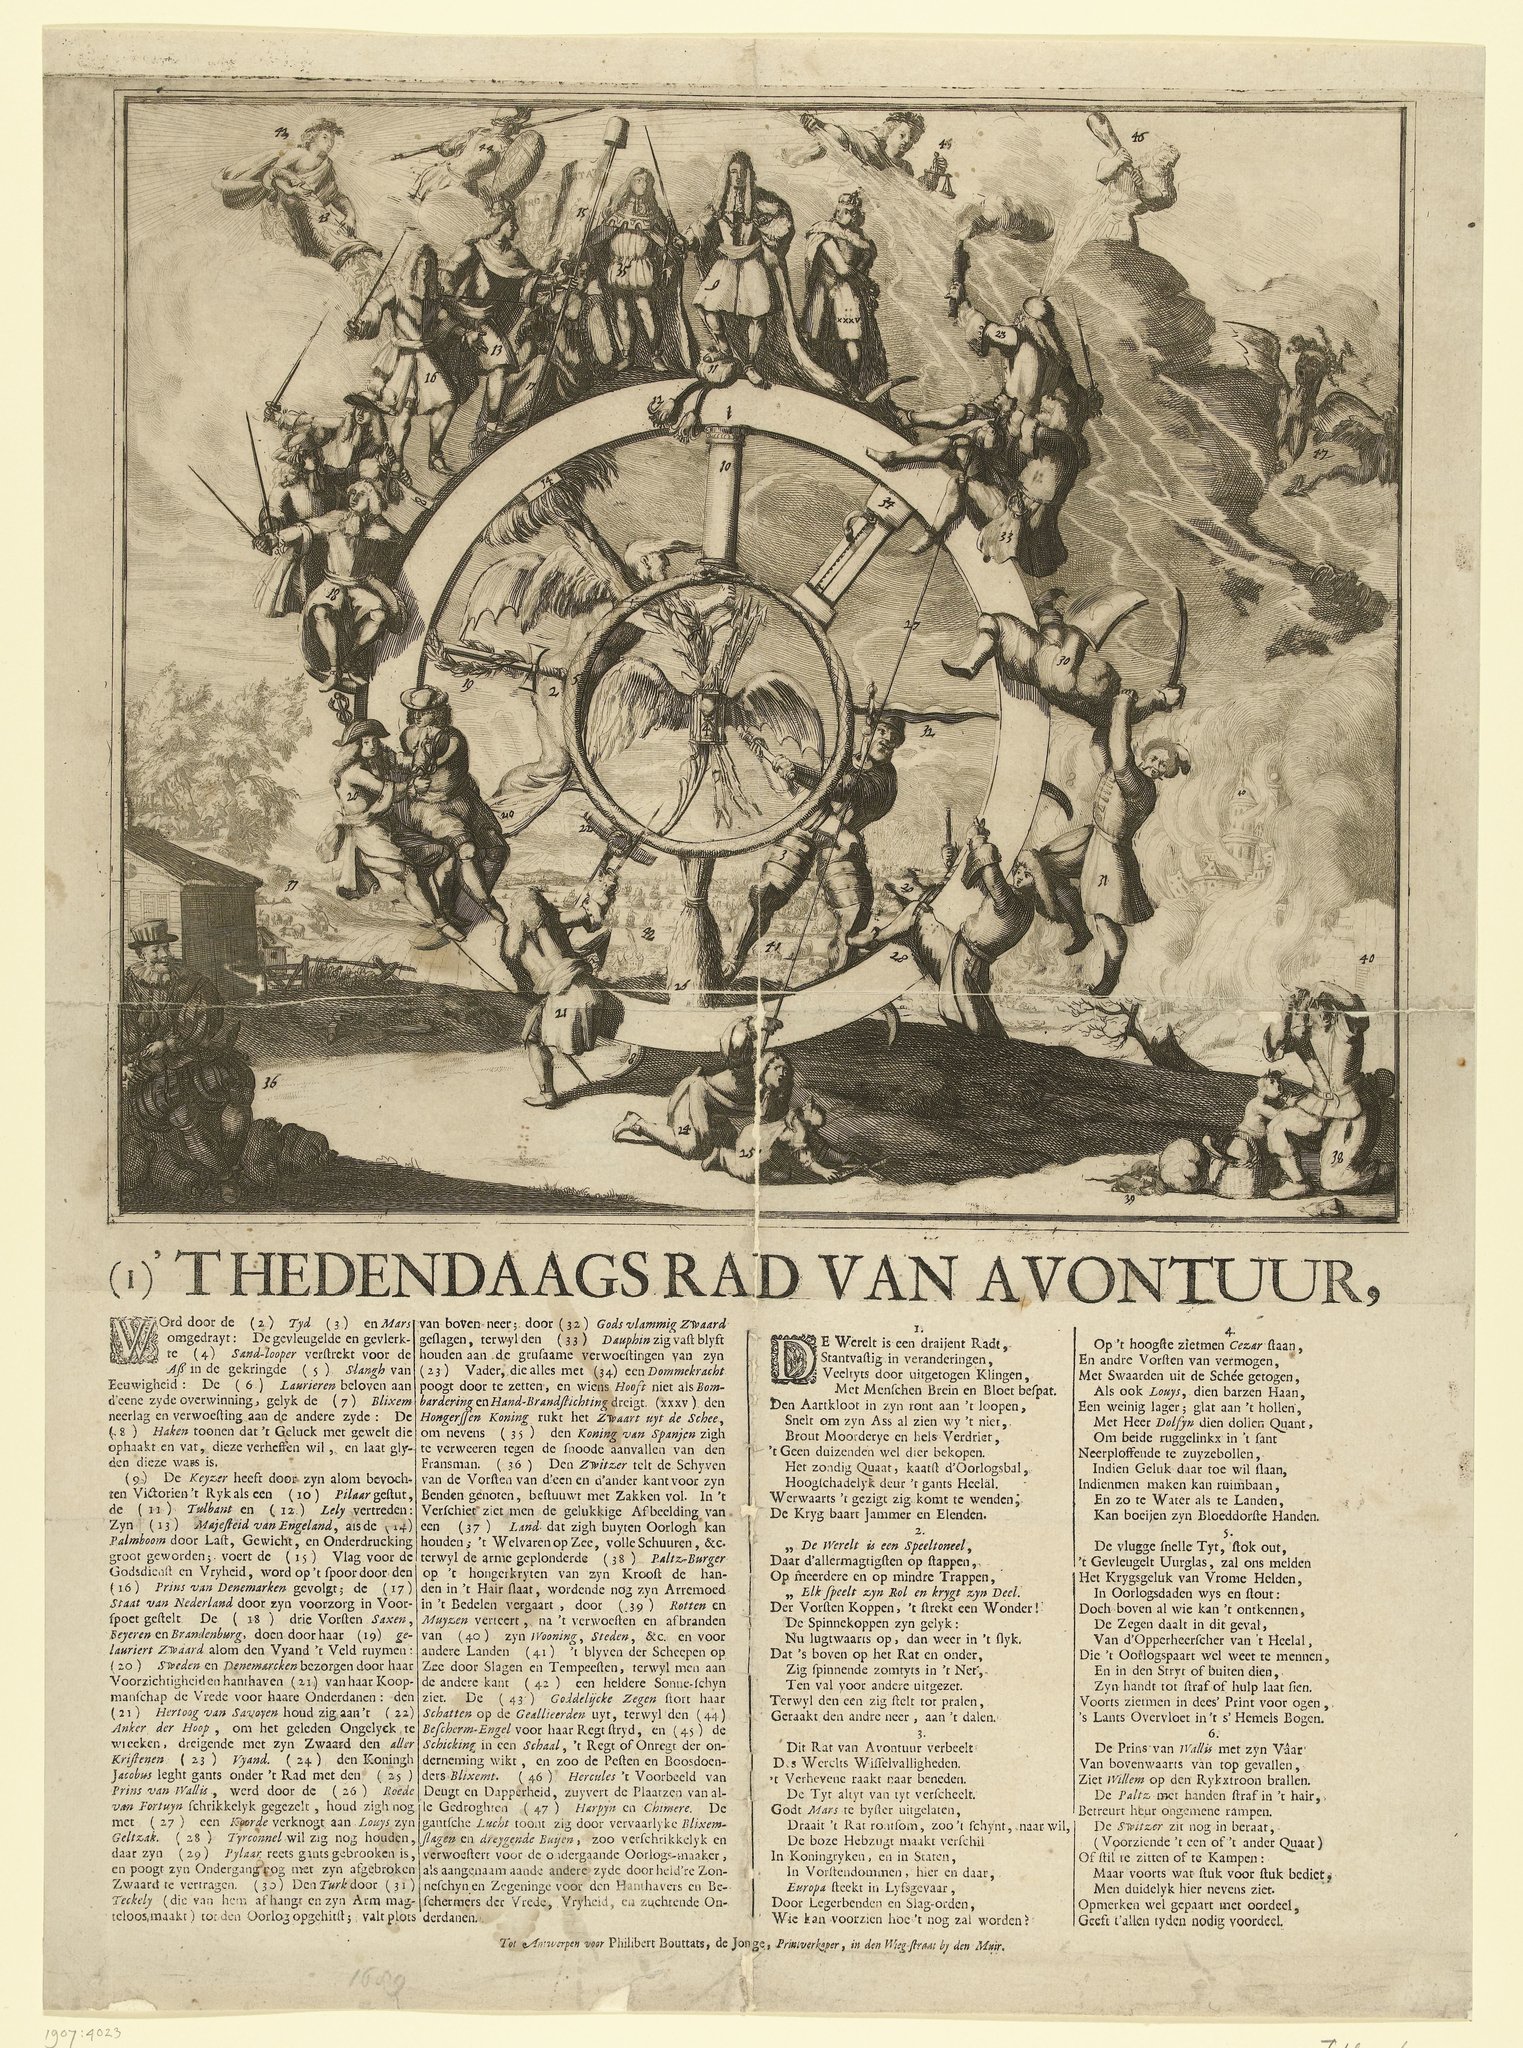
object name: cartoon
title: Karikaturen op Jacobus II en Lodewijk XIV en de gebeurtenissen in de jaren 1688-1689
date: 1689-1690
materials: paper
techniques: etching, letterpress printing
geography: antwerp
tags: jacobus ii (koning van engeland en schotland), lodewijk xiv (koning van frankrijk), vienna, leopold i (keizer van duitsland), dauphin van frankrijk lodewijk, karel ii (koning van spanje), london, rome, turn of fate, wheel of fortune, political caricatures and satires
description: Het rad van fortuin, ca. 1689. Spotprent op de val van de katholiek vorsten Jacobus II en Lodewijk XIV. Bovenaan het rad de vorsten keizer Leopold I en koning Karel II van Spanje. In opkomst o.a. de Nederlandse Maagd. Lodewijk XIV, de dauphin en de Turken vallen van het rad. Onderaan op de grond zit koning Jacobus II met het ondergeschoven kind. Het rad wordt gedraaid door Mars en Chronos. Onder de voorstelling een verklaring van de cijfers 1-47 en een gedicht in 6 verzen in het Nederlands.